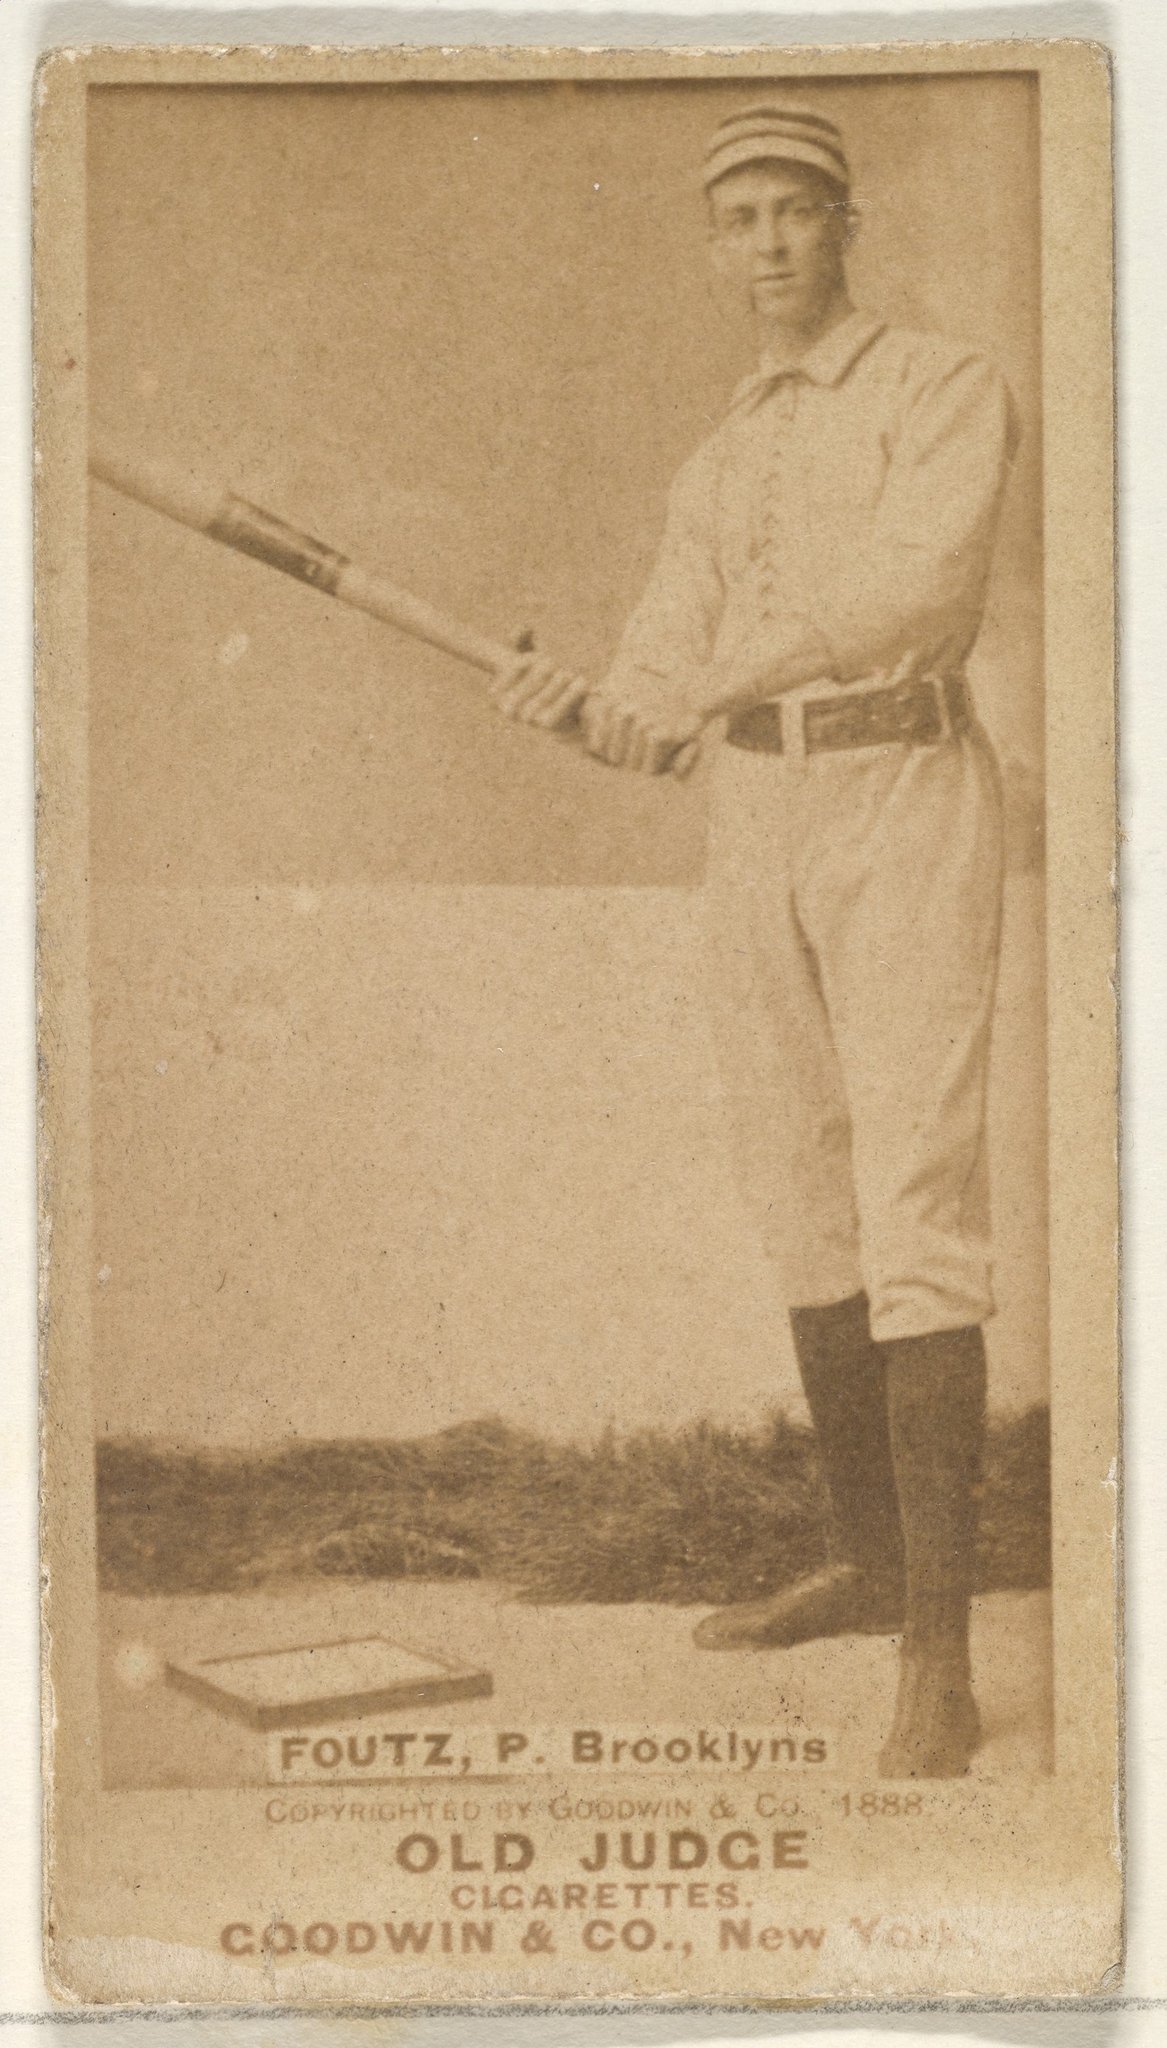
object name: baseball card, photograph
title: Foutz, Pitcher, Brooklyn Bridegrooms, from the Old Judge series (N172) for Old Judge Cigarettes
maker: goodwin & company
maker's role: publisher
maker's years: 1850-1950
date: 1888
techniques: albumen silver print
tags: men,portraits,baseball,athletes